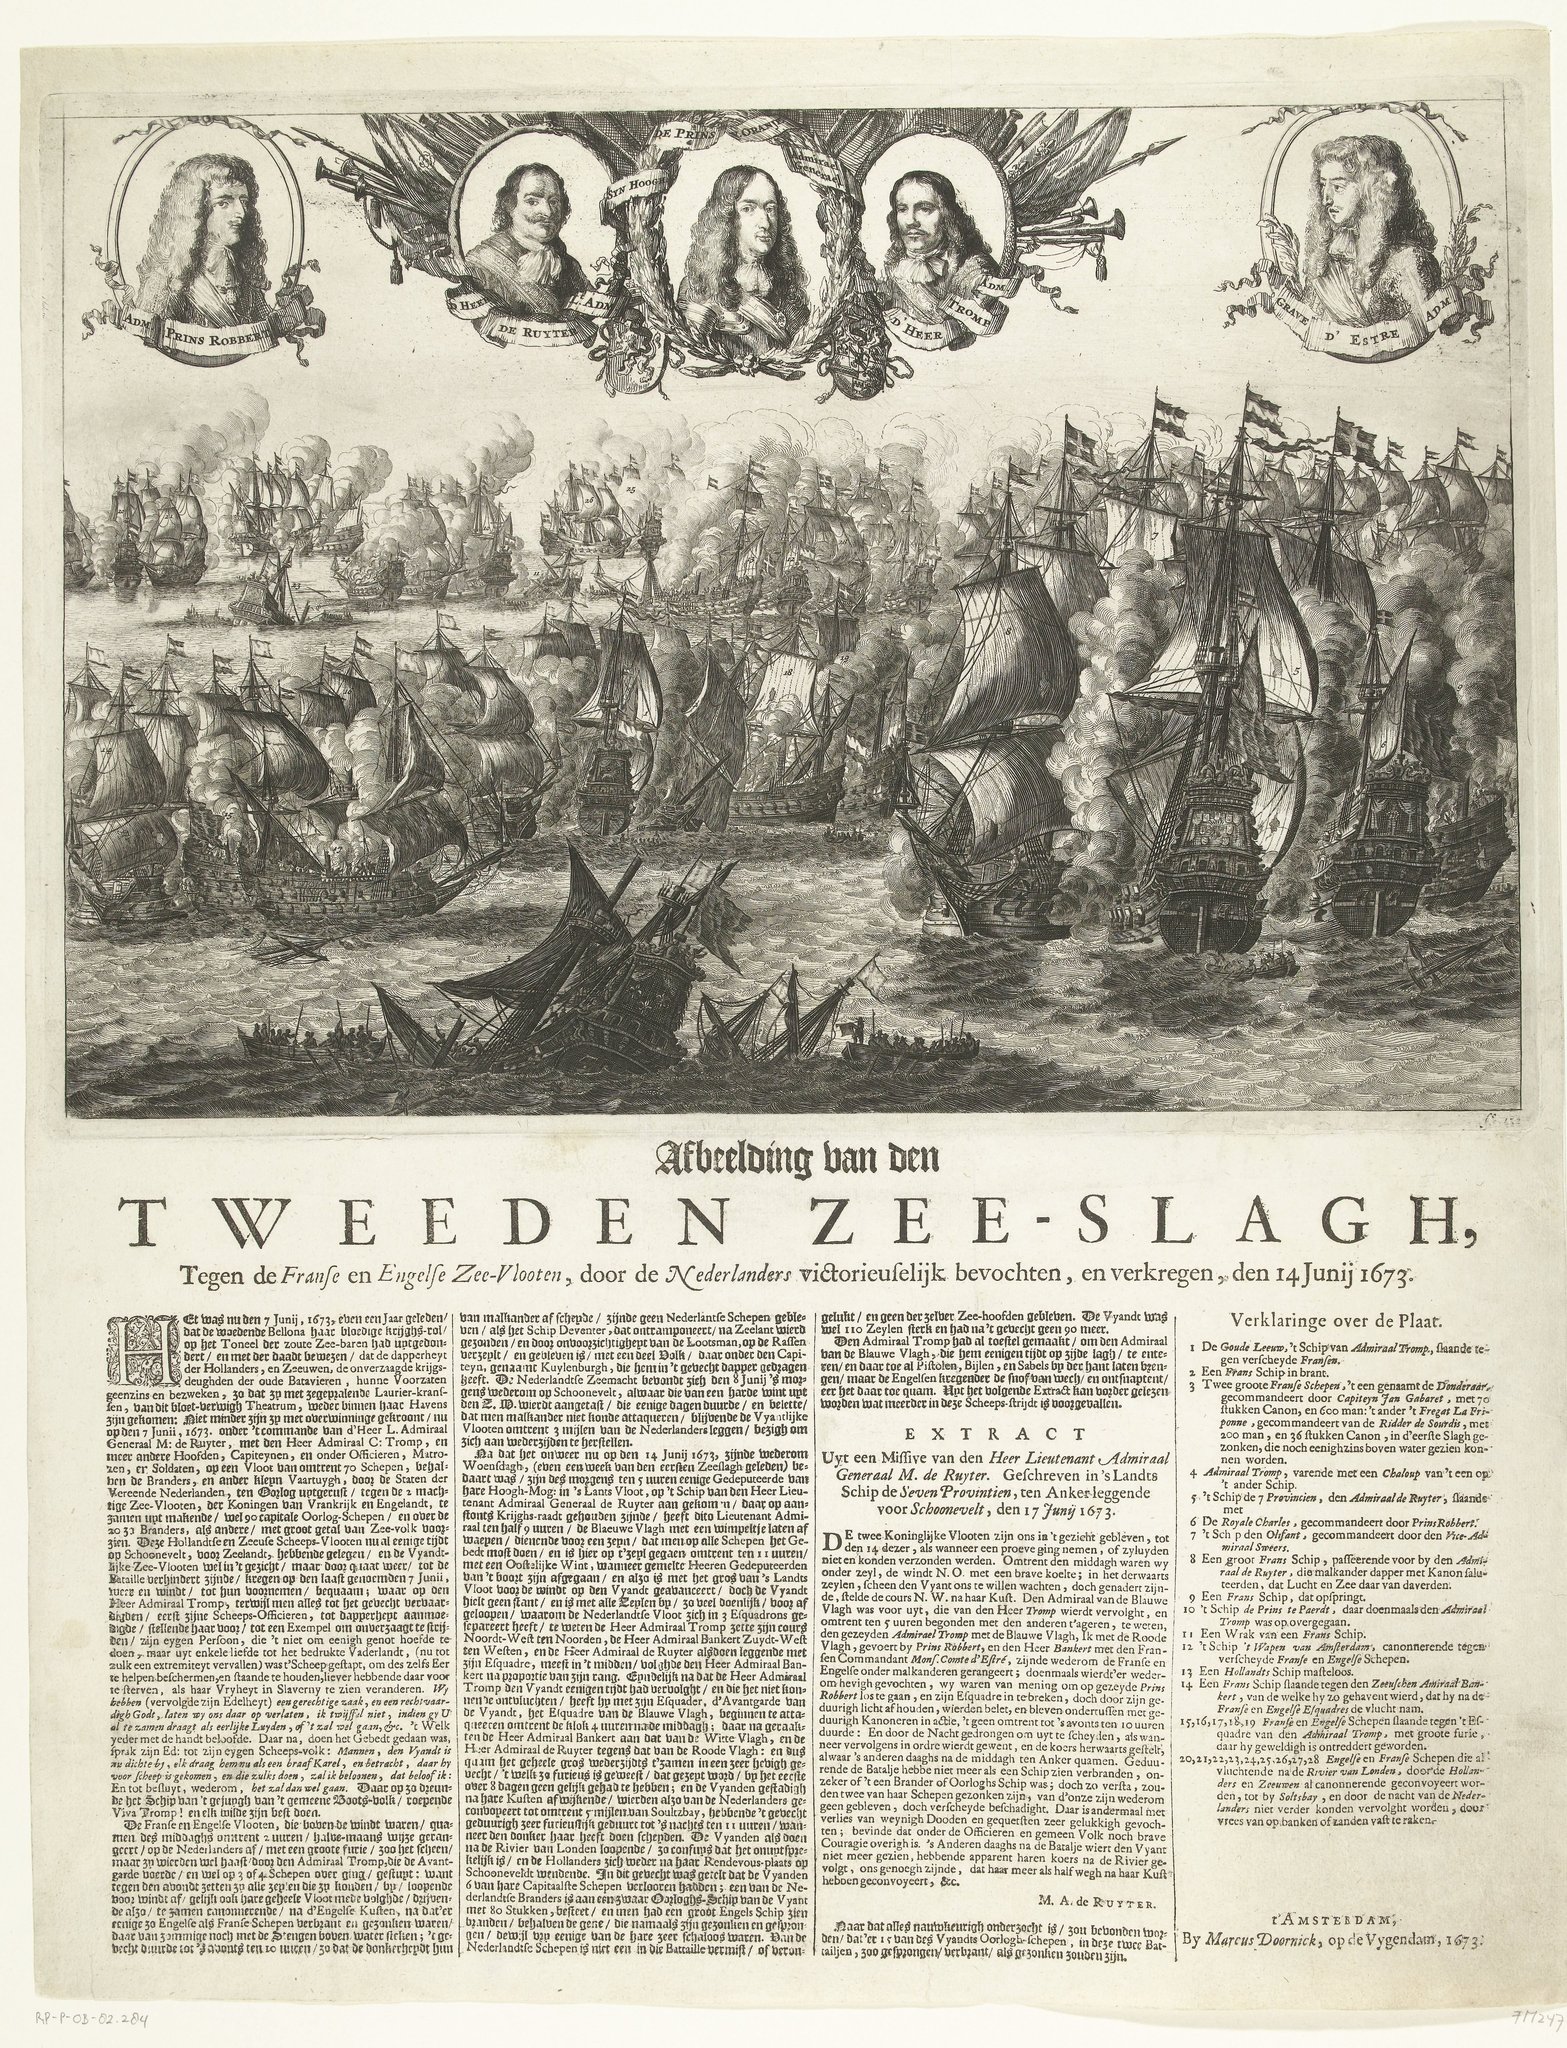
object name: print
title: Afbeelding van den Tweeden Zee-slagh, Tegen de Franse en Engelse Zee-vlooten, door de Nederlanders Victorieuselijk bevochten, en verkregen, den 14 Junij 1673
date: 1673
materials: paper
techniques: etching, letterpress printing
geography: amsterdam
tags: prague, london, print maker, draughtsman, prinz ruprecht, flushing, michiel adriaenszoon de ruyter, rotterdam, amsterdam, cornelis tromp, the hague, william iii (prince of orange and king of england, scotland, and ireland), battle (+ naval force), second battle of schooneveld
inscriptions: date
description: De zeeslag op Schoonevelt op 14 juni 1673 tussen de vloot van de Republiek onder Michiel Adriaenszoon de Ruyter en Cornelis Tromp en de gecombineerde Engels-Franse vloot onder Prins Rupert en graaf Jean d'Estrées. Bovenaan de portretten van prins Rupert, Michiel Adriaenszoon de Ruyter, prins Willem III en Cornelis Tromp en de graaf d'Estrées. Gedrukt op het blad onder de plaat is een tekst in 4 kolommen, met een extract uit de missive van De Ruyter van 17 juni 1673 en de legenda 1-28.